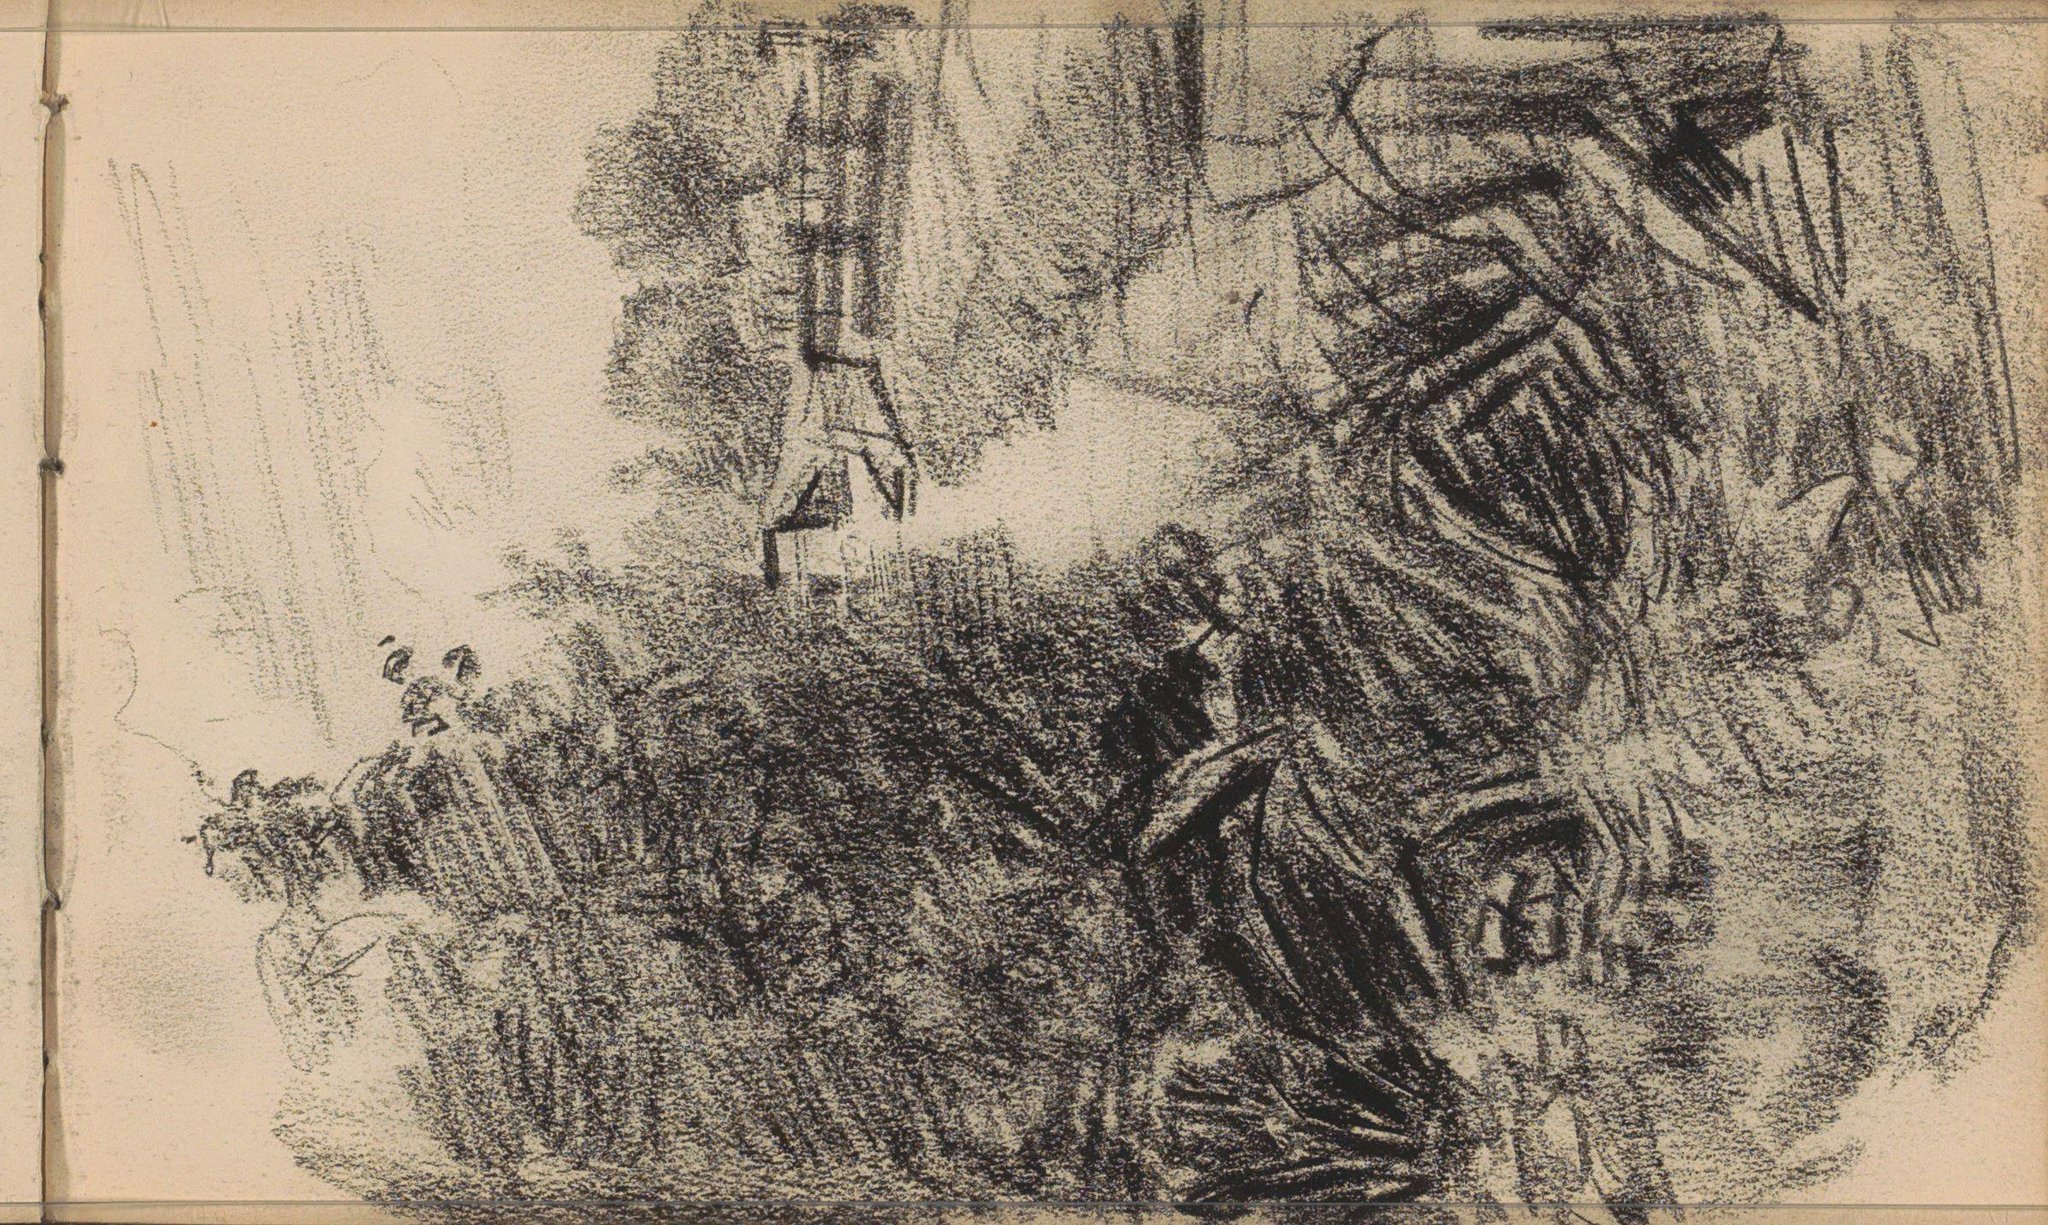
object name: sketchbook leaf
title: Landschap met water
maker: johan antonie de jonge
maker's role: draughtsman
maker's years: 1864-1927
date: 1901-1927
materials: chalk, paper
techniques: stumping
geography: south holland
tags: water course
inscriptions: kleurnotitie, handgeschreven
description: Landschap met water. Blad 10 uit een schetsboek met 45 bladen.